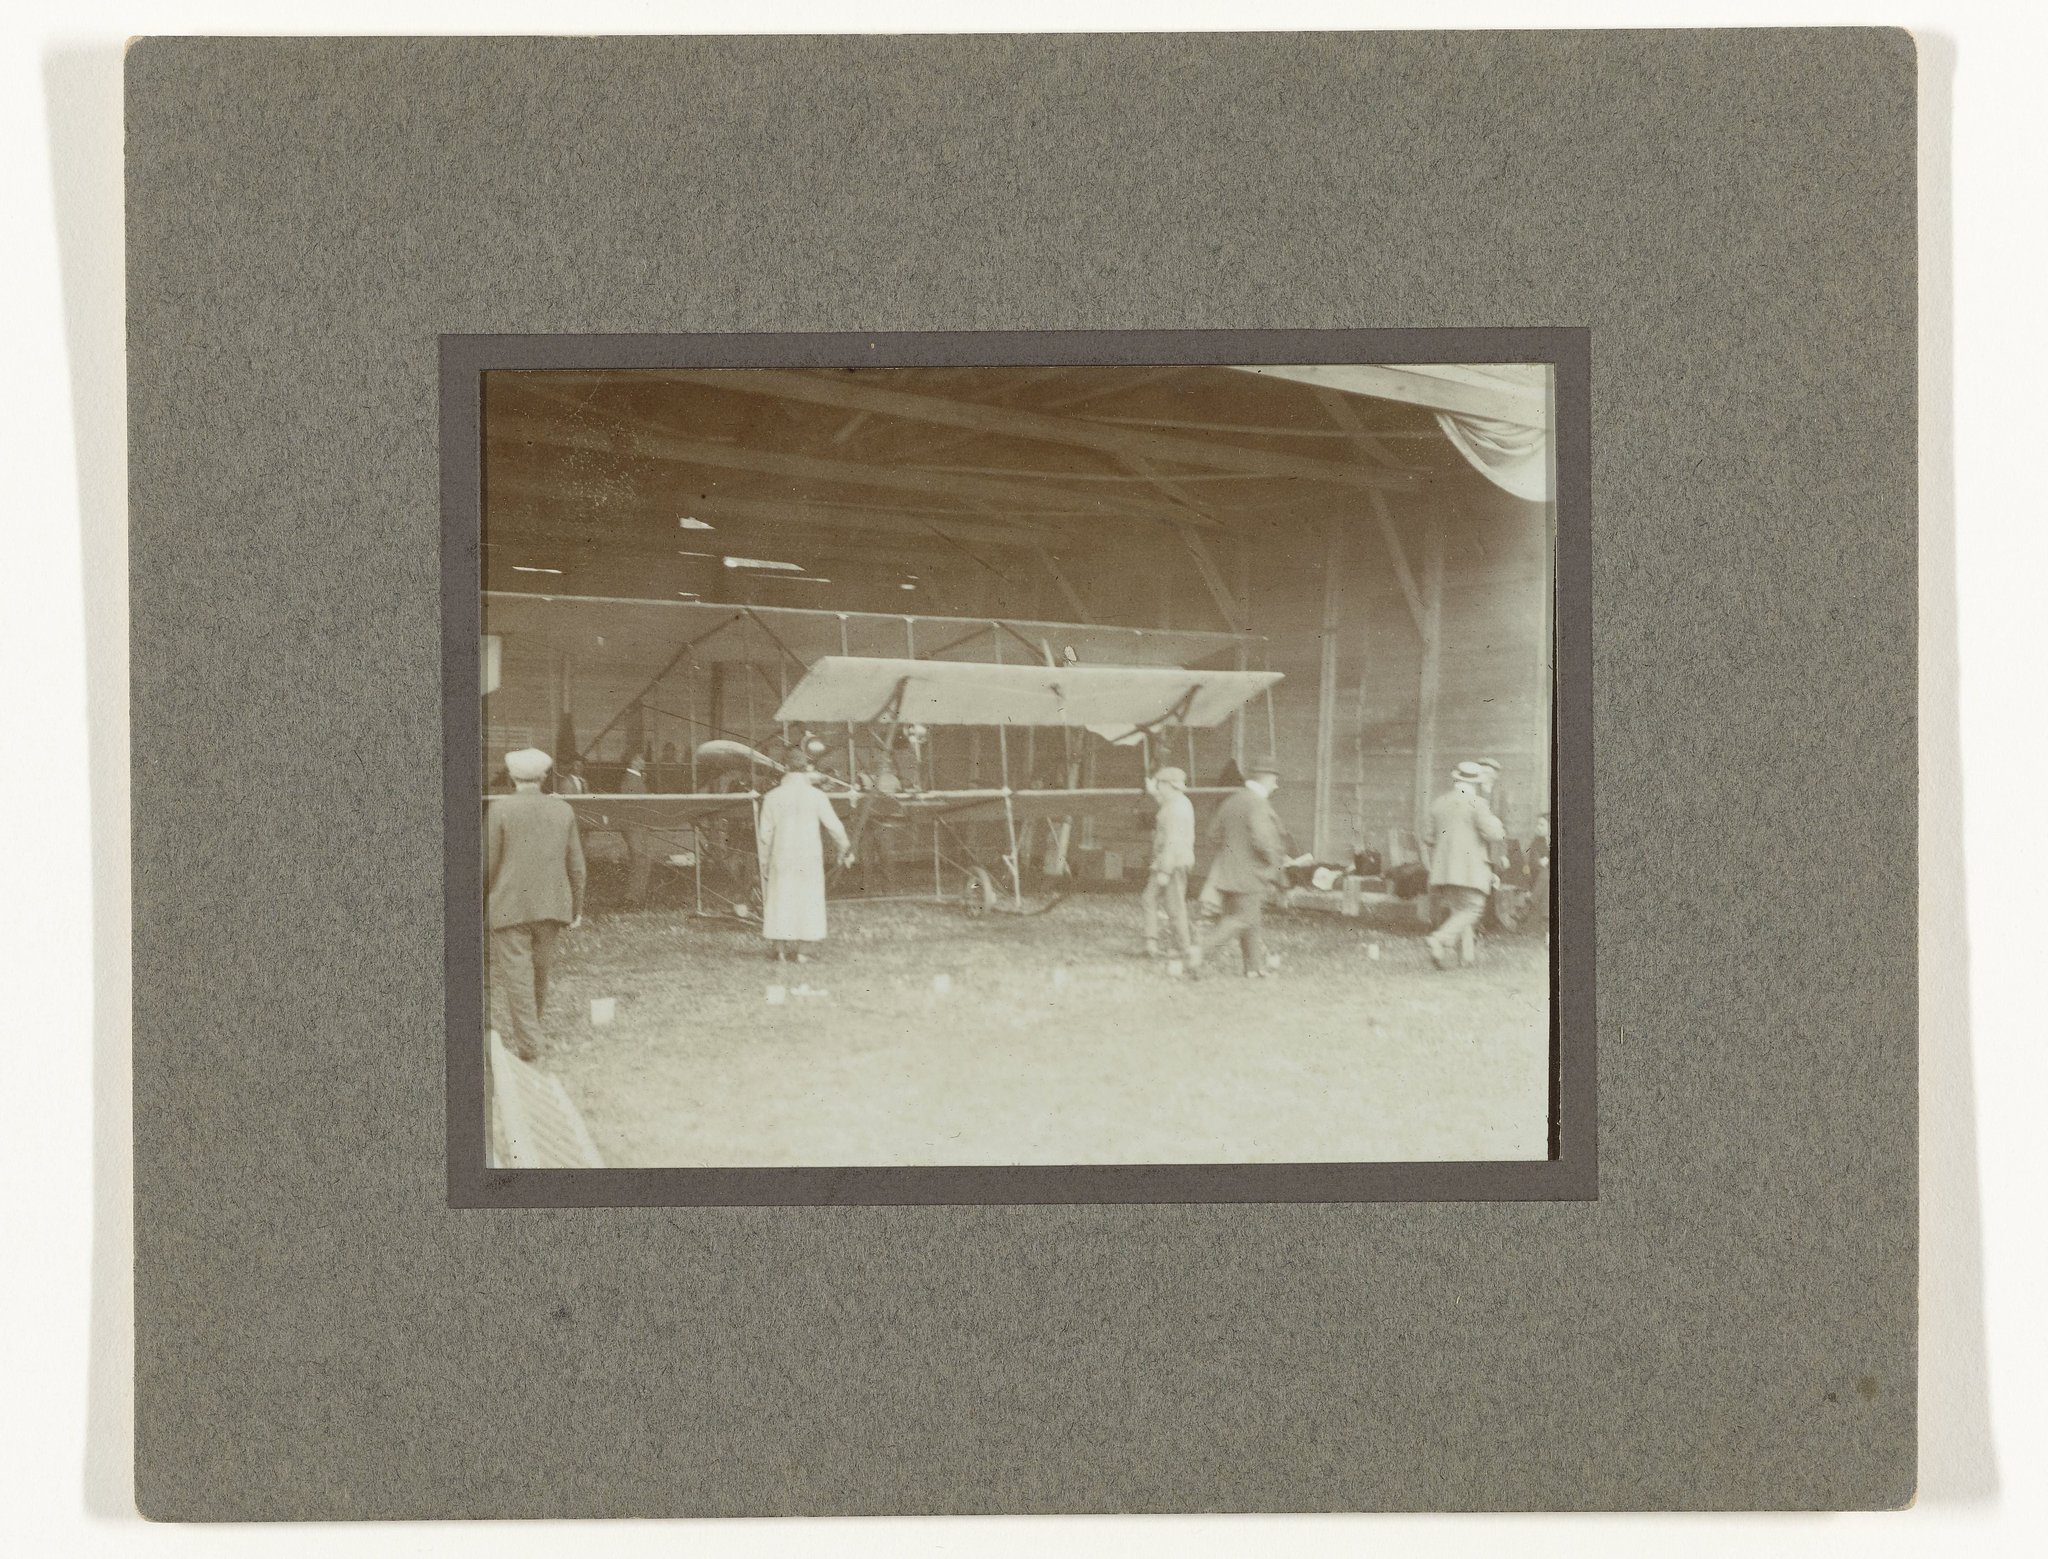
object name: photograph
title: De eerste vliegvlucht van Clément van Maasdijk bij Heereveen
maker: e. ten cate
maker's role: fotograaf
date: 1910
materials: cardboard, photographic support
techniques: gelatin silver print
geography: heerenveen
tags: the hague, aircraft, aeroplane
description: Een aantal mannen bezig met een vliegtuig dat in een hangar staat.